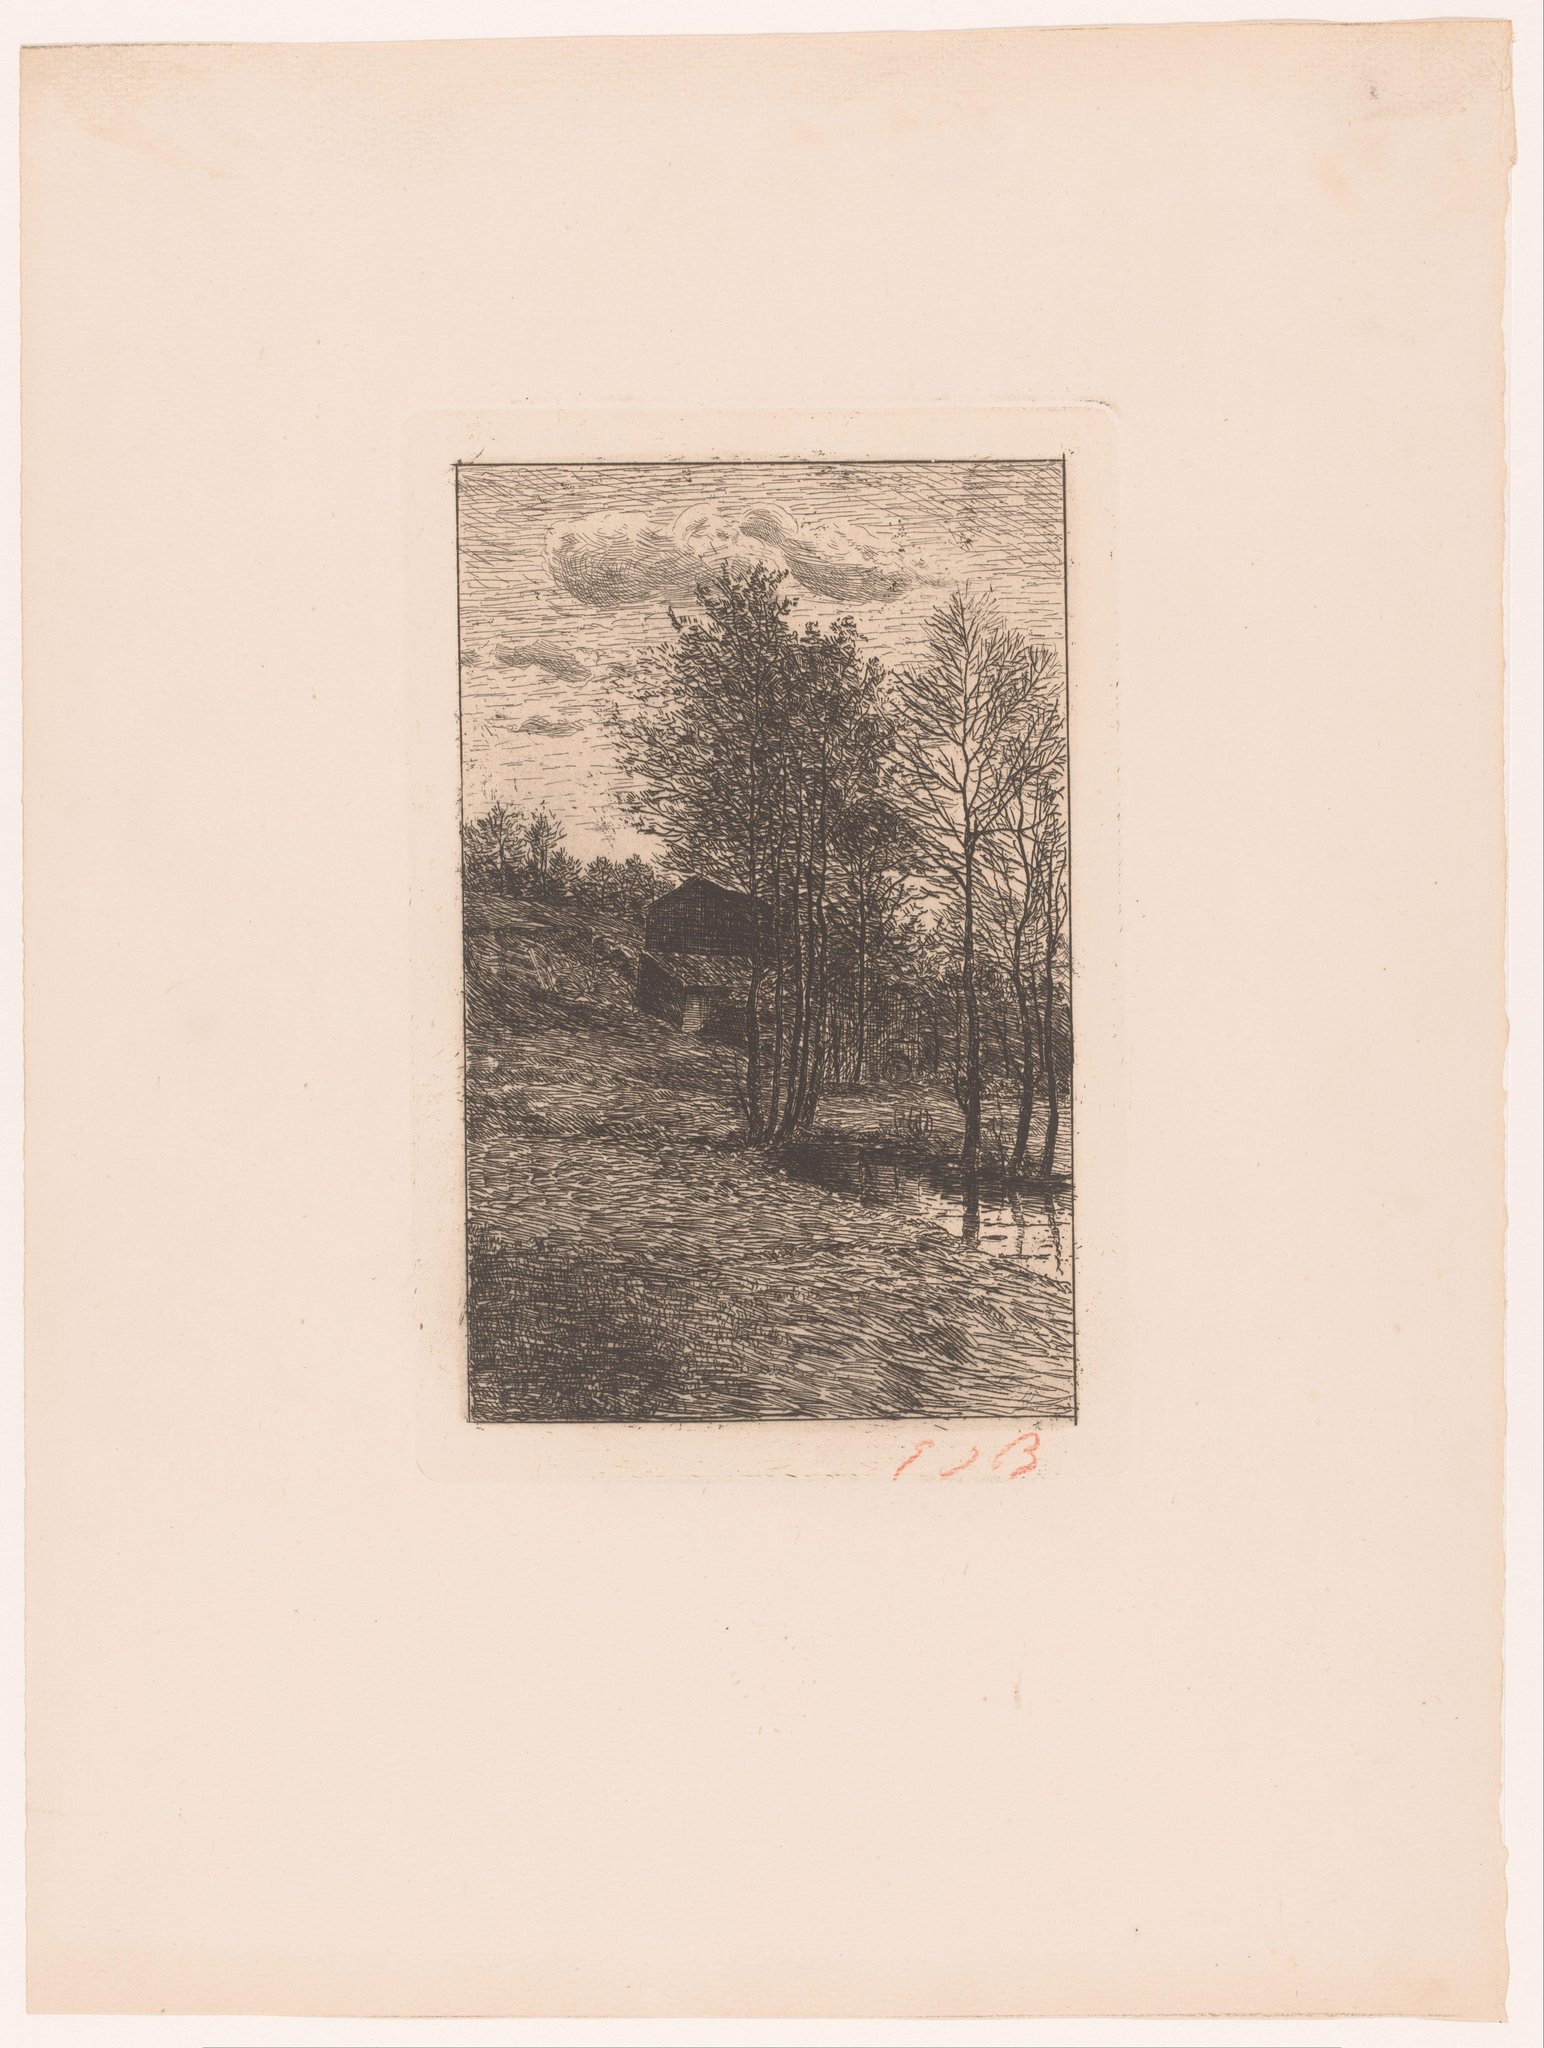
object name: print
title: Een klein gebouw op een heuvelhelling in een bosrijke omgeving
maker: emile de baré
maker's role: painter, print maker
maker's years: 1855-1902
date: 1865-1902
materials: paper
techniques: drypoint, etching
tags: farm or solitary house in landscape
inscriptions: collector's mark: Lugt 2228